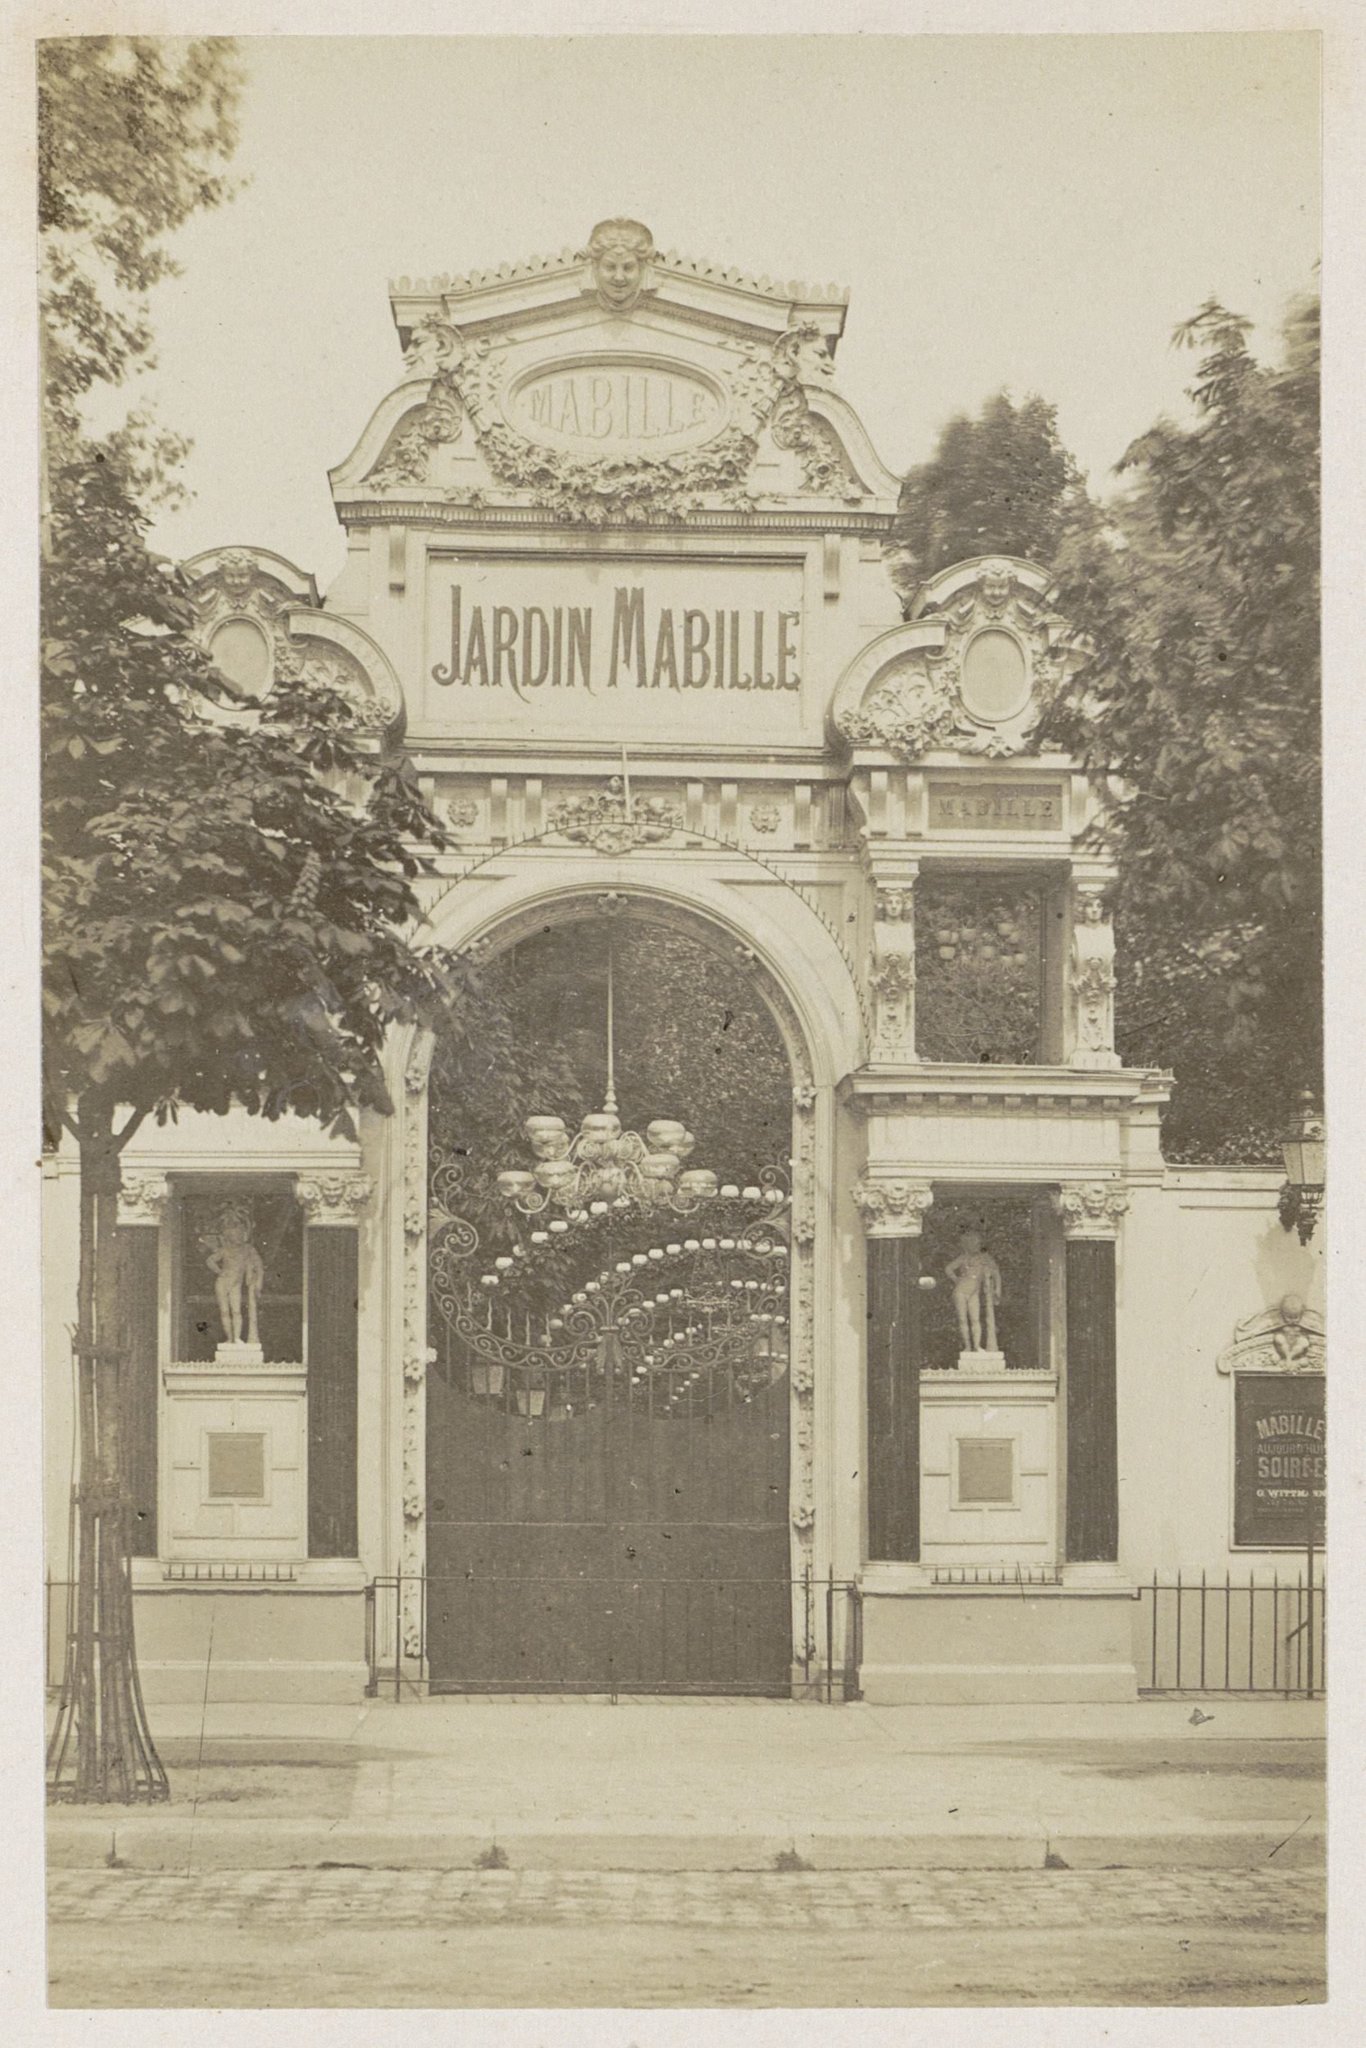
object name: photograph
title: Ingang van de Jardin Mabille, een dansgelegenheid in Parijs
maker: Anonymous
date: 1878-1890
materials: photographic support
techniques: albumen print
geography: paris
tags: night-club, dance-hall (+ variant), gate, entrance, paris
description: Onderdeel van Reisalbum Europese steden, vermoedelijk Zweeds.